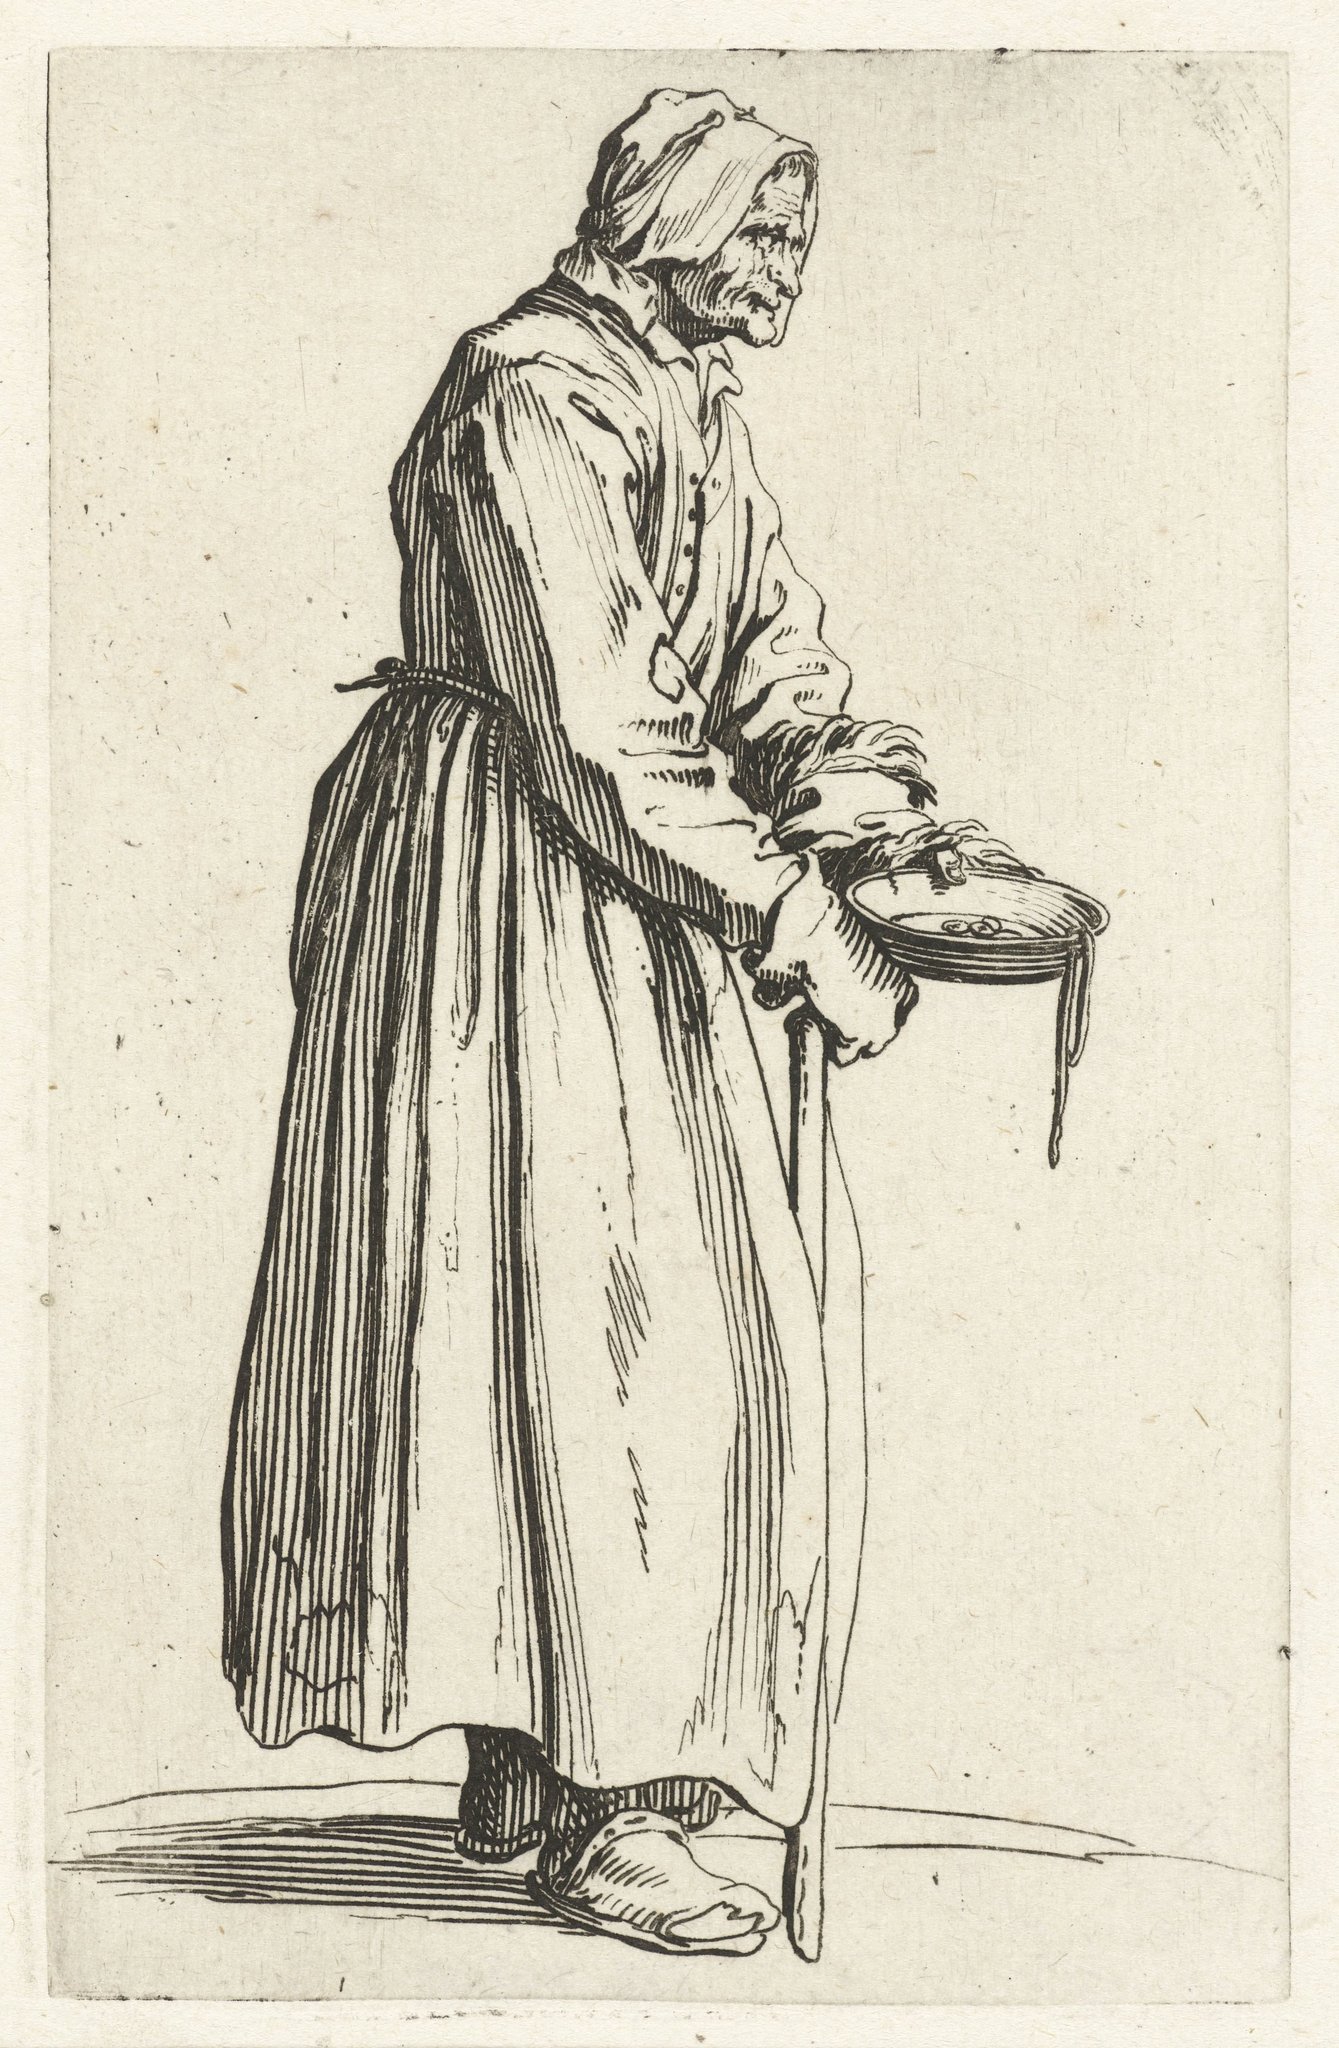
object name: print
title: Bedelares met een centenbakje en een stok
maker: jacques callot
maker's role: draughtsman, print maker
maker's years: 1592-1635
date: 1622-1623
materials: paper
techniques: etching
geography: nancy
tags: walking-stick, staff, begging bowl, beggar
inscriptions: collector's mark: Lugt 240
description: Vrouw, gekleed in lompen, op de rechterzijde gezien, een centenbakje in de linkerhand, een stok in de rechterhand. Deze prent is onderdeel van een serie van 25 prenten met bedelaars en zwervers, zoals Callot die waarschijnlijk in Italië heeft gezien.